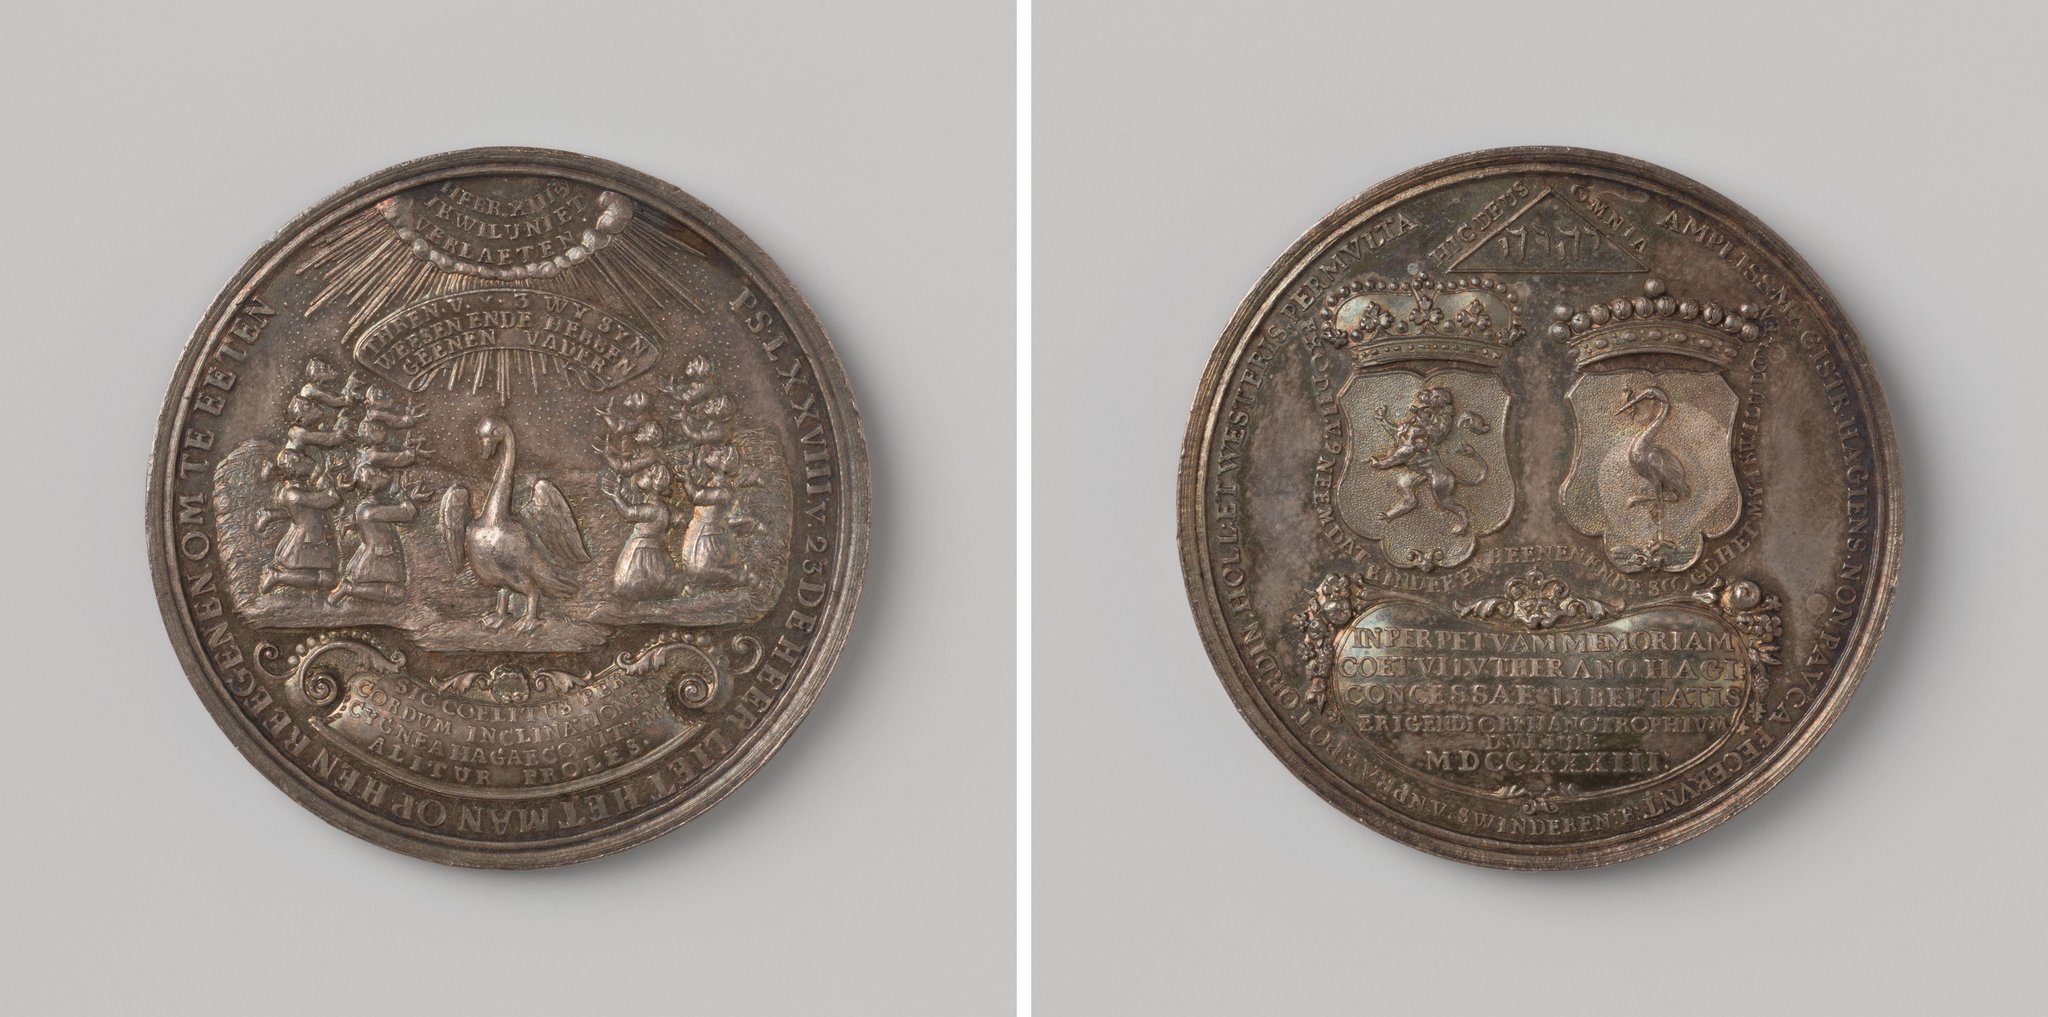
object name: history medal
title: Oprichting van een Luthers weeshuis in 's-Gravenhage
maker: nicolaas van swinderen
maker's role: jeweler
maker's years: 1705-1760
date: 1733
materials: silver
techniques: striking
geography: the hague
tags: luthers weeshuis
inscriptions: inscription: ‘THREN.V.V.3 WY SYN/ WEESEN ENDE HEBBEN/ GEENEN VADER.’, inscription: ‘EXOD. II V.9: NEEM DAT KINDEKEN HEENEN ENDE SOOGD HET MY, IK WIL U LOONEN’, circumscription: ‘AMPLISS. MAGISTR. HAGIENS. NON PAVCA FECERVNT PRAEPOT. ORDIN. HOLL. ET WESTFRIS. PERMVLTA’, inscription: ‘HIC DEUS OMNIA’, inscription: ‘HEBR. XIII 5/ IK WIL V NIET/ VERLAETEN’, caption: ‘SIC COELITUS PER/ CORDUM INCLINATIONUM/ CYGNEA HAGAE COMITUM/ ALITUR PROLES’, circumscription: ‘PS. LXXVIII. V. 23 DE HEER LIET HET MAN OP HEN REEGENEN OM TE EETEN.’, caption: ‘IN PERPETVAM MEMORIAM/ COETVI LVTHERANO HAGI:/ CONCESSAE LIBERTATIS/ ERIGENDI ORPHANOTROPHIVM/ D. VI. IUN:/ MDCXXXIII:’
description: Zilveren penning. Voorzijde: beschenen door hemellicht met daarin opschrift en onder wimpel met opschrift bidden knielende weesjongens en weesmeisjes, van elkaar gescheiden door een zwaan, boven versierde wimpel met opschrift binnen omschrift. Keerzijde: onder een driehoek met daarin naam van Jehova in het Hebreeuws en binnen een omschrift: twee gekroonde wapenschilden omgeven door een opschrift, boven een cartouche met opschrift binnen omschrift.